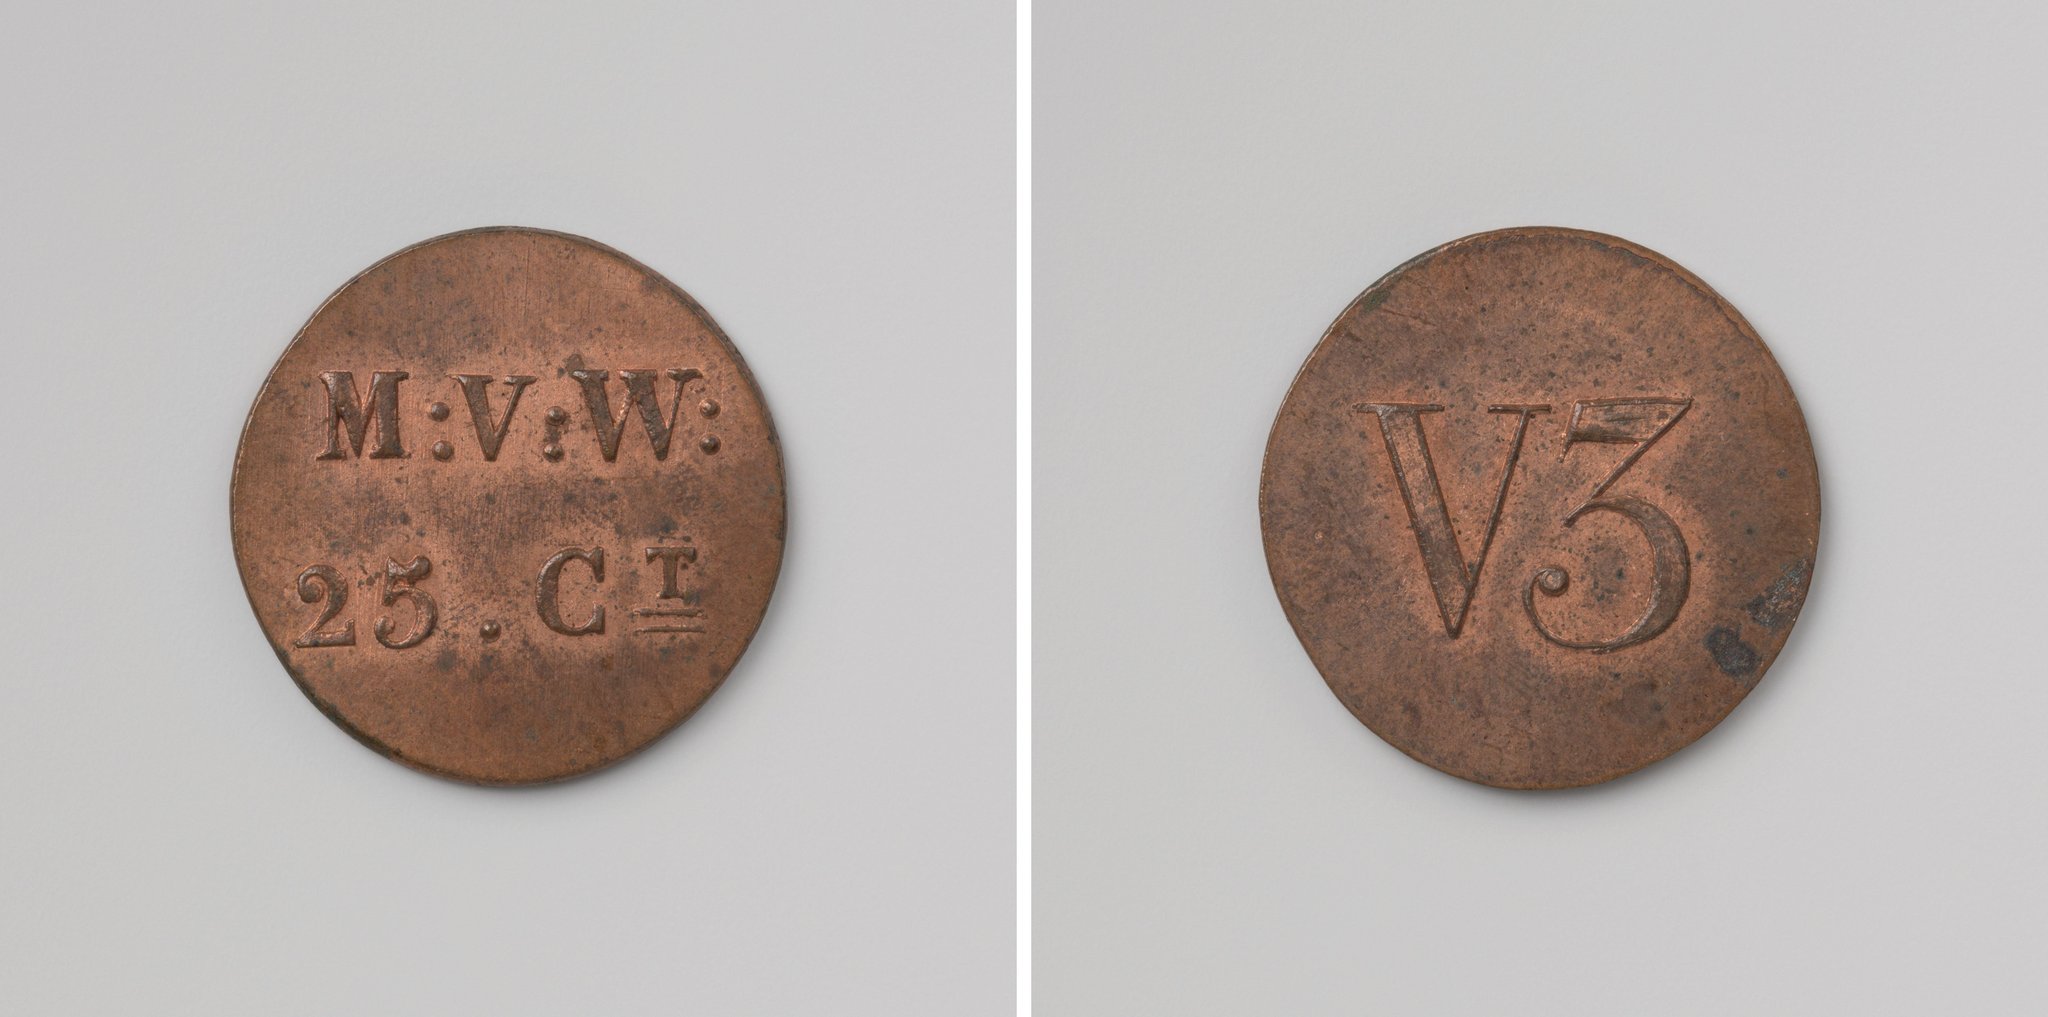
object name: huismunt prison money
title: Derde gesticht van de strafkolonie Veenhuizen, huismunt geslagen op last van de Maatschappij van Weldadigheid ter waarde van 25 cent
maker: Anonymous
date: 1818-1859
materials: copper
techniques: striking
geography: netherlands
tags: maatschappij van weldadigheid, veenhuizen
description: Voorzijde: opschrift boven waardeaanduiding. Keerzijde: opschrift V 3